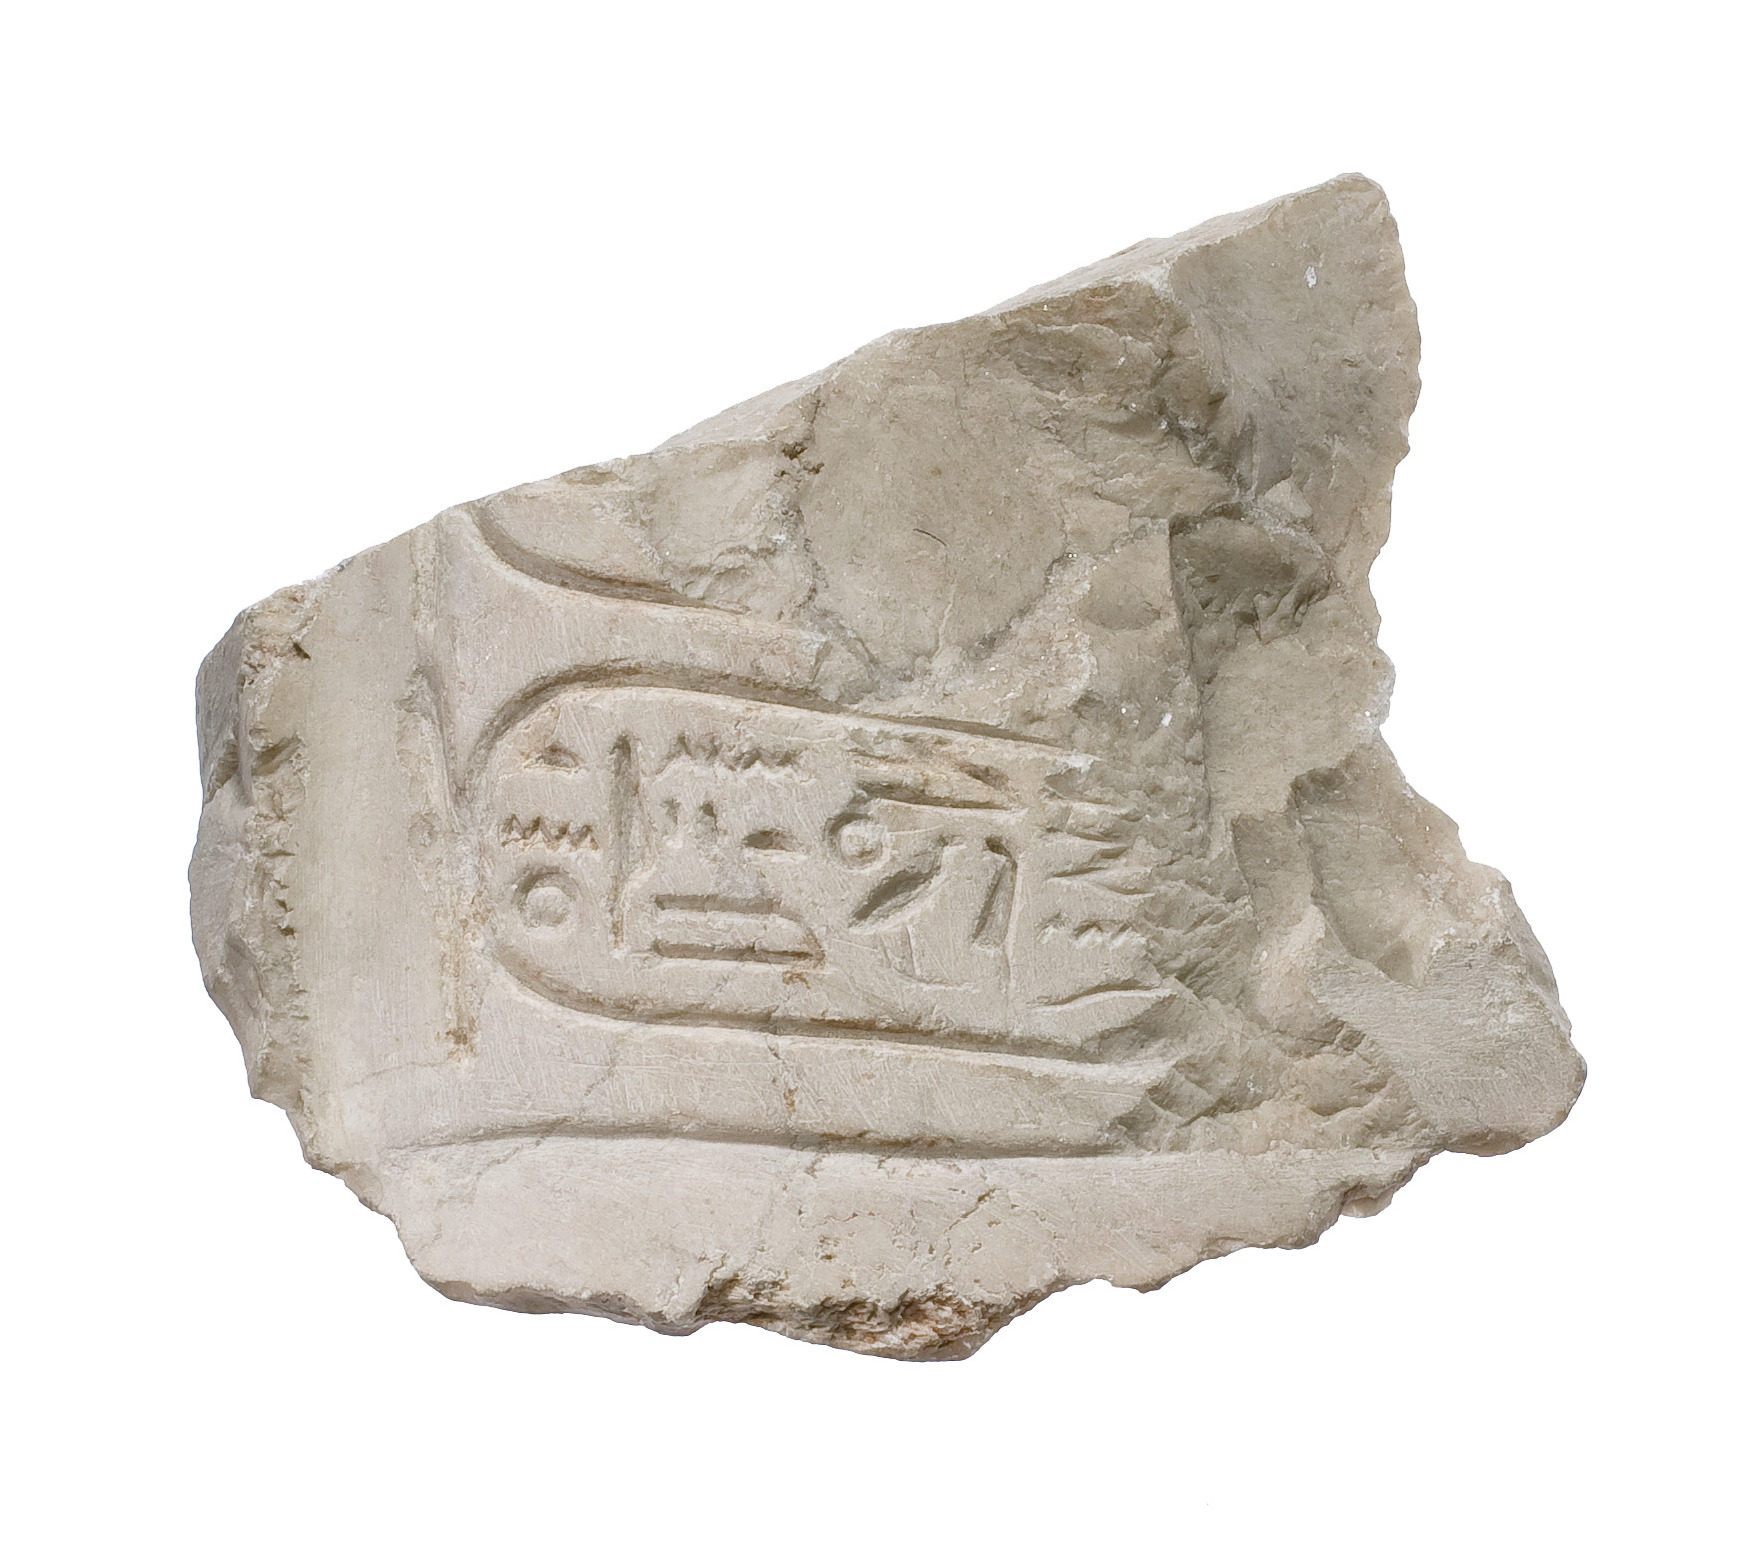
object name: torso belt of akhenaten fragment, cartouch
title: Torso/belt of the king with Aten cartouches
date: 1353-1336 BCE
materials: limestone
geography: egypt